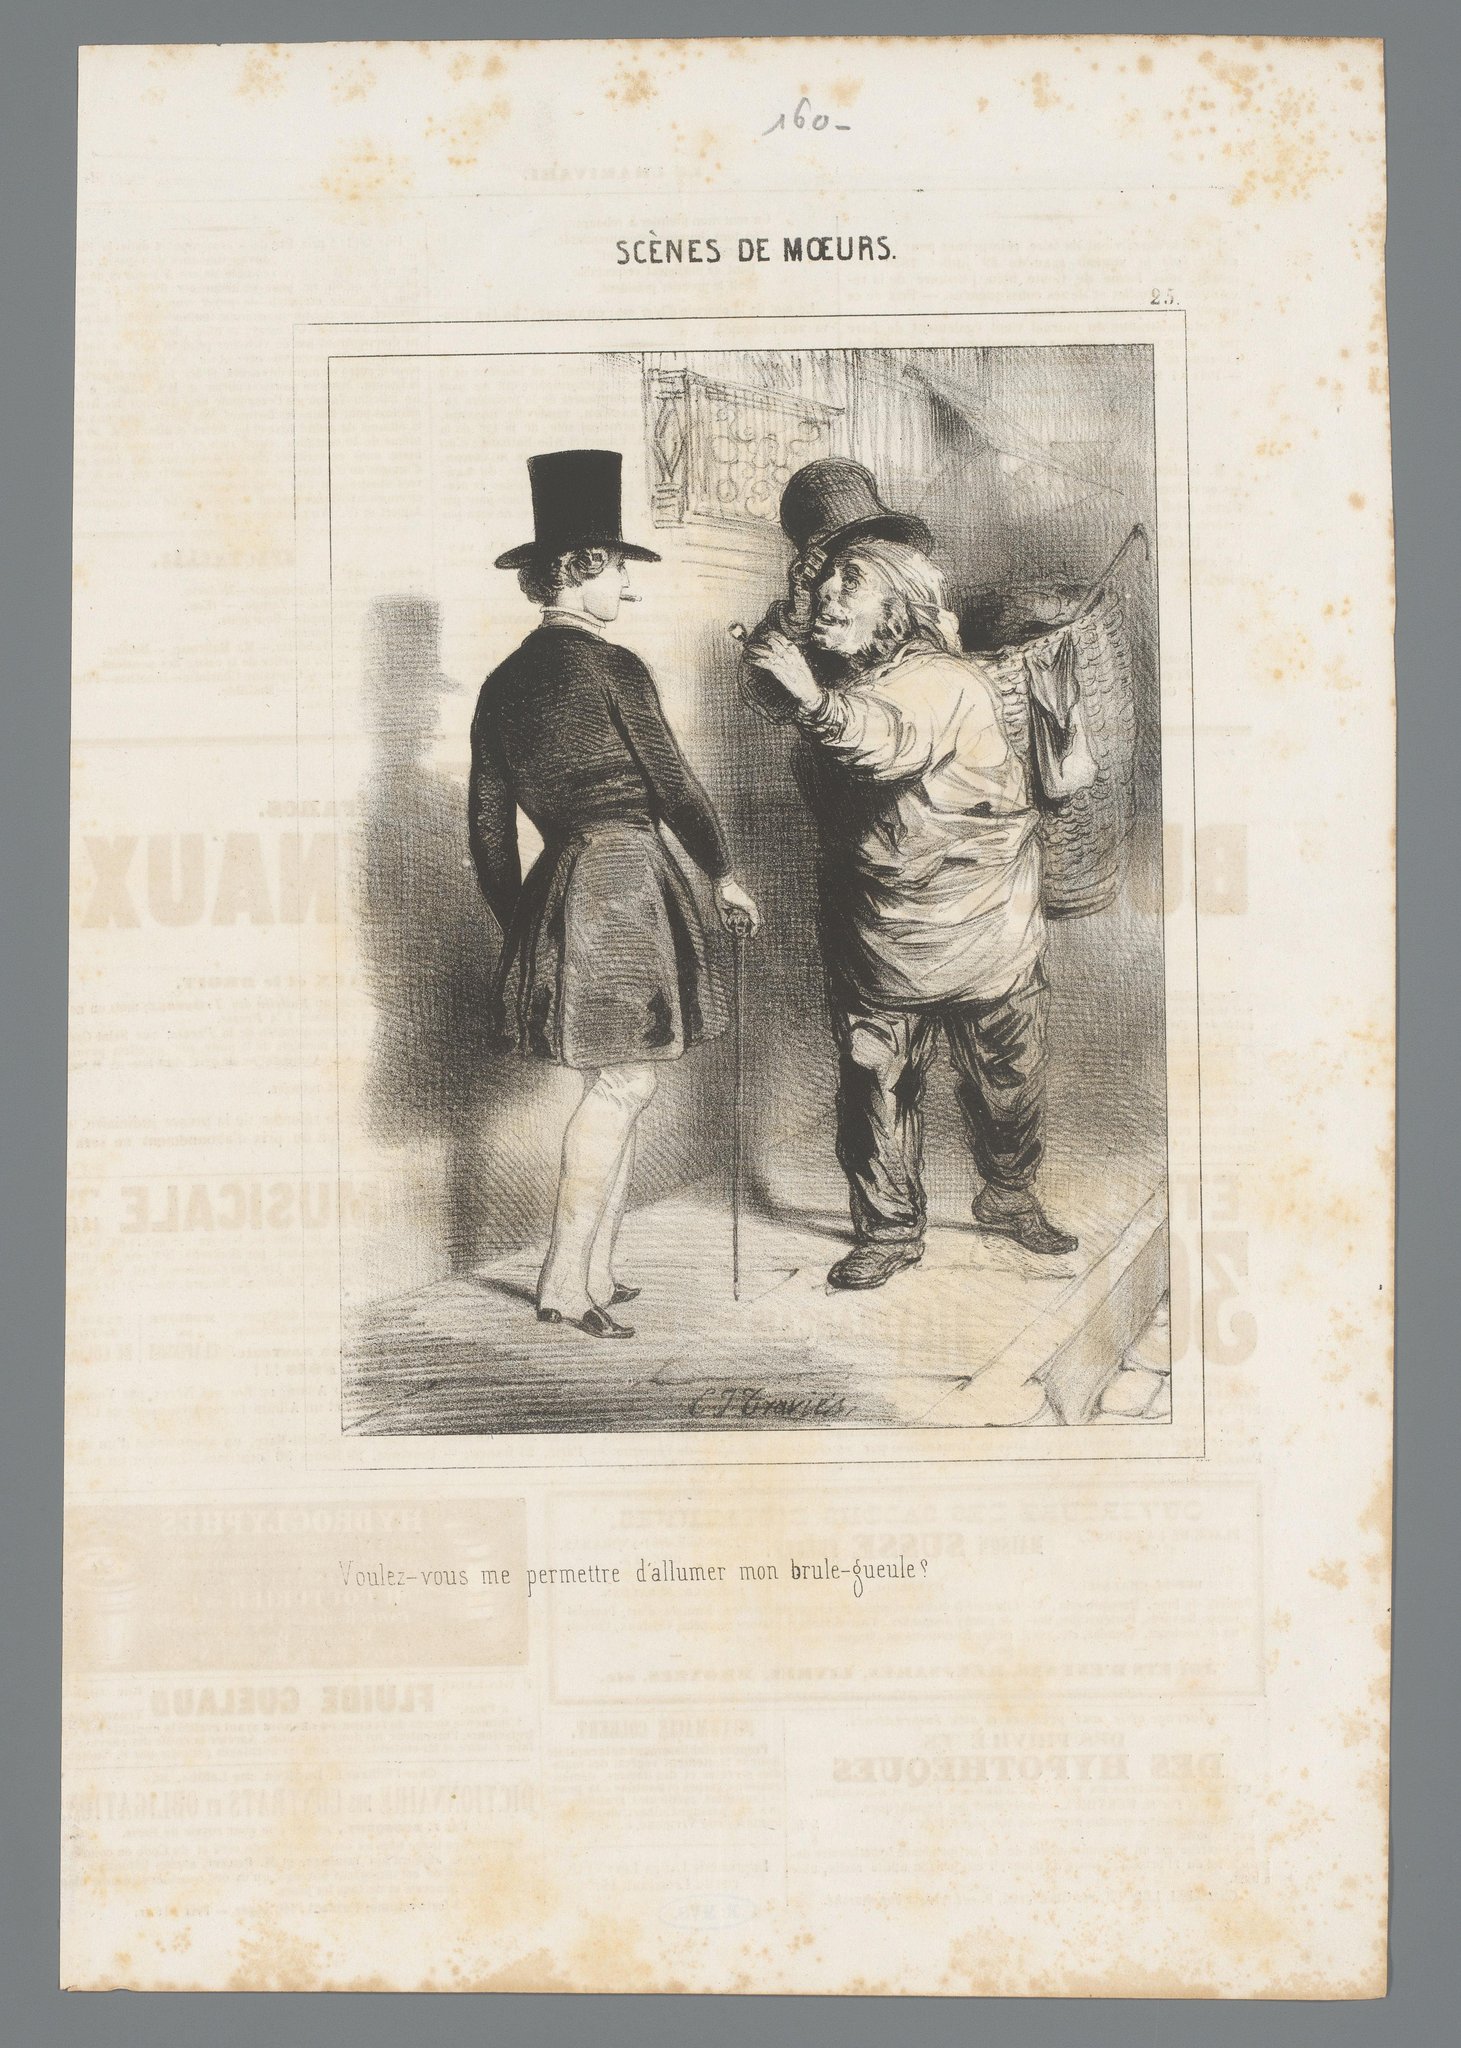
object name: cartoon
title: Man vraagt andere man om een vuurtje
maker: charles-joseph traviès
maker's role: print maker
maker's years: 1804-1859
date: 1842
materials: paper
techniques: letterpress printing, lithograph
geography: paris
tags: adult man, tobacco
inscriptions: collector's mark: Lugt 2228